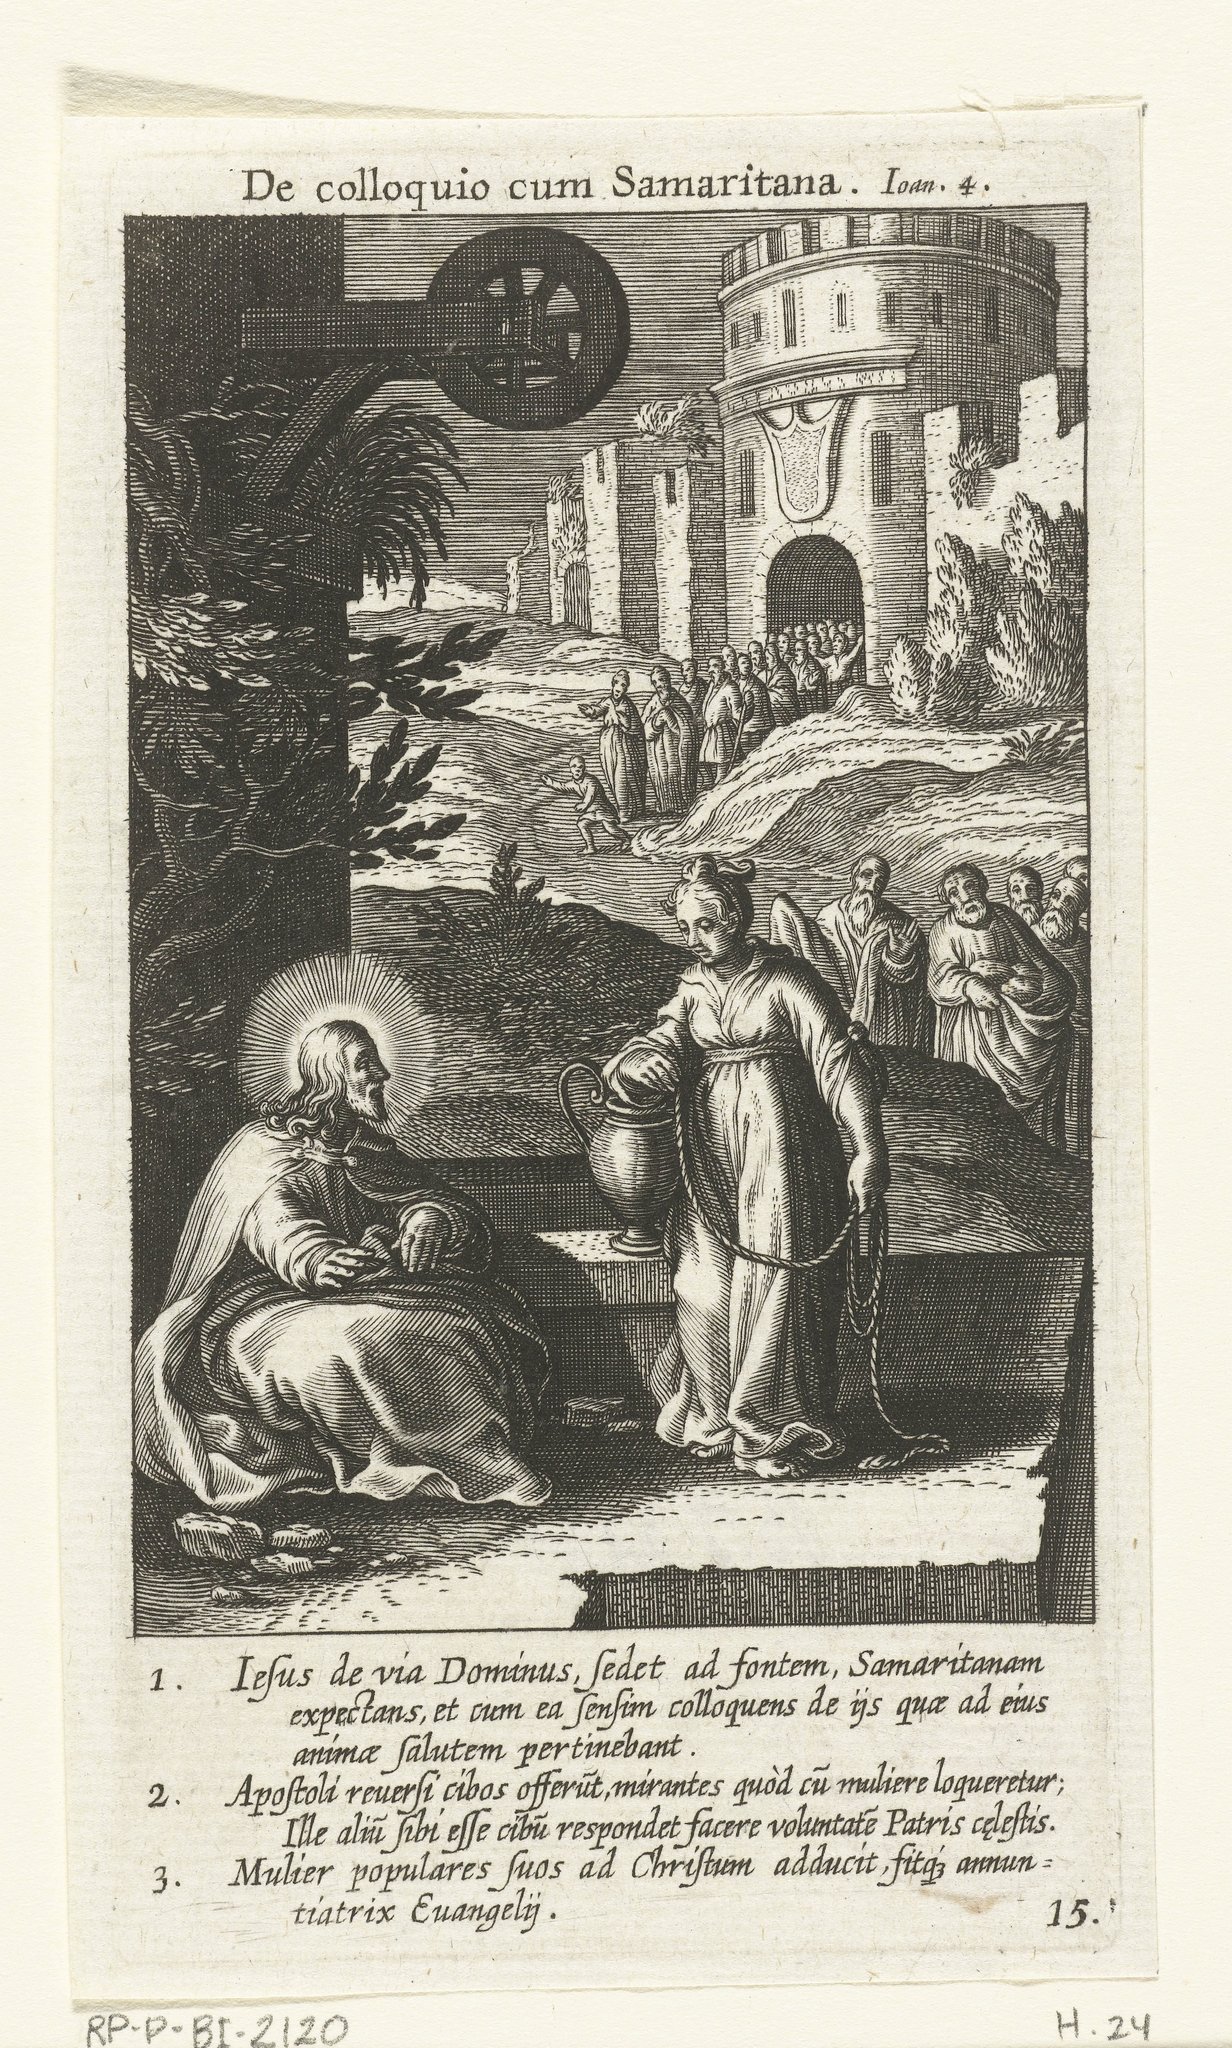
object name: book illustration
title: Vitae passionis et mortis Jesu Christ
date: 1590-1622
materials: paper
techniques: engraving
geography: antwerp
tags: christ and the woman of samaria: sitting at jacob's well he asks her for a drink from her jug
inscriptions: collector's mark: Lugt 240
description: Prent uit: Joannes Bourgois, Vitae passionis et mortis Jesu Christi Somini nostri mysteria, Antwerpen Hendrick Aertssens, 1622, afb. 15